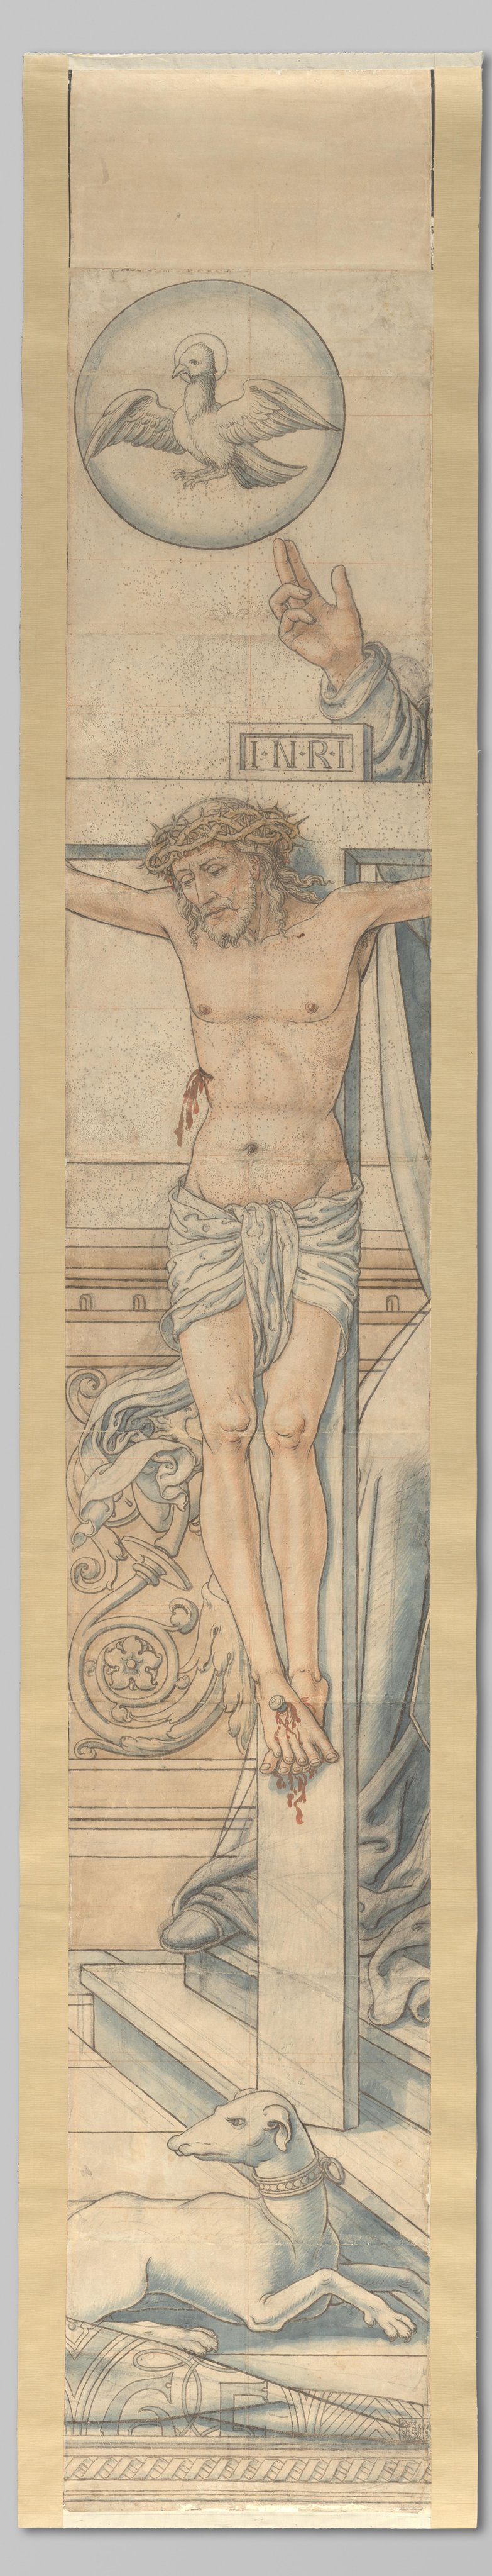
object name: drawing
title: Fragmenten karton voor het glasraam in de westgevel van Joris van Egmond (Bisschop van Utrecht 1535-1559) voor de Sint Bavo Kerk te Haarlem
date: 1541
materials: chalk, charcoal, paper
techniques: brush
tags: joris van egmond, sint-bavokerk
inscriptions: date